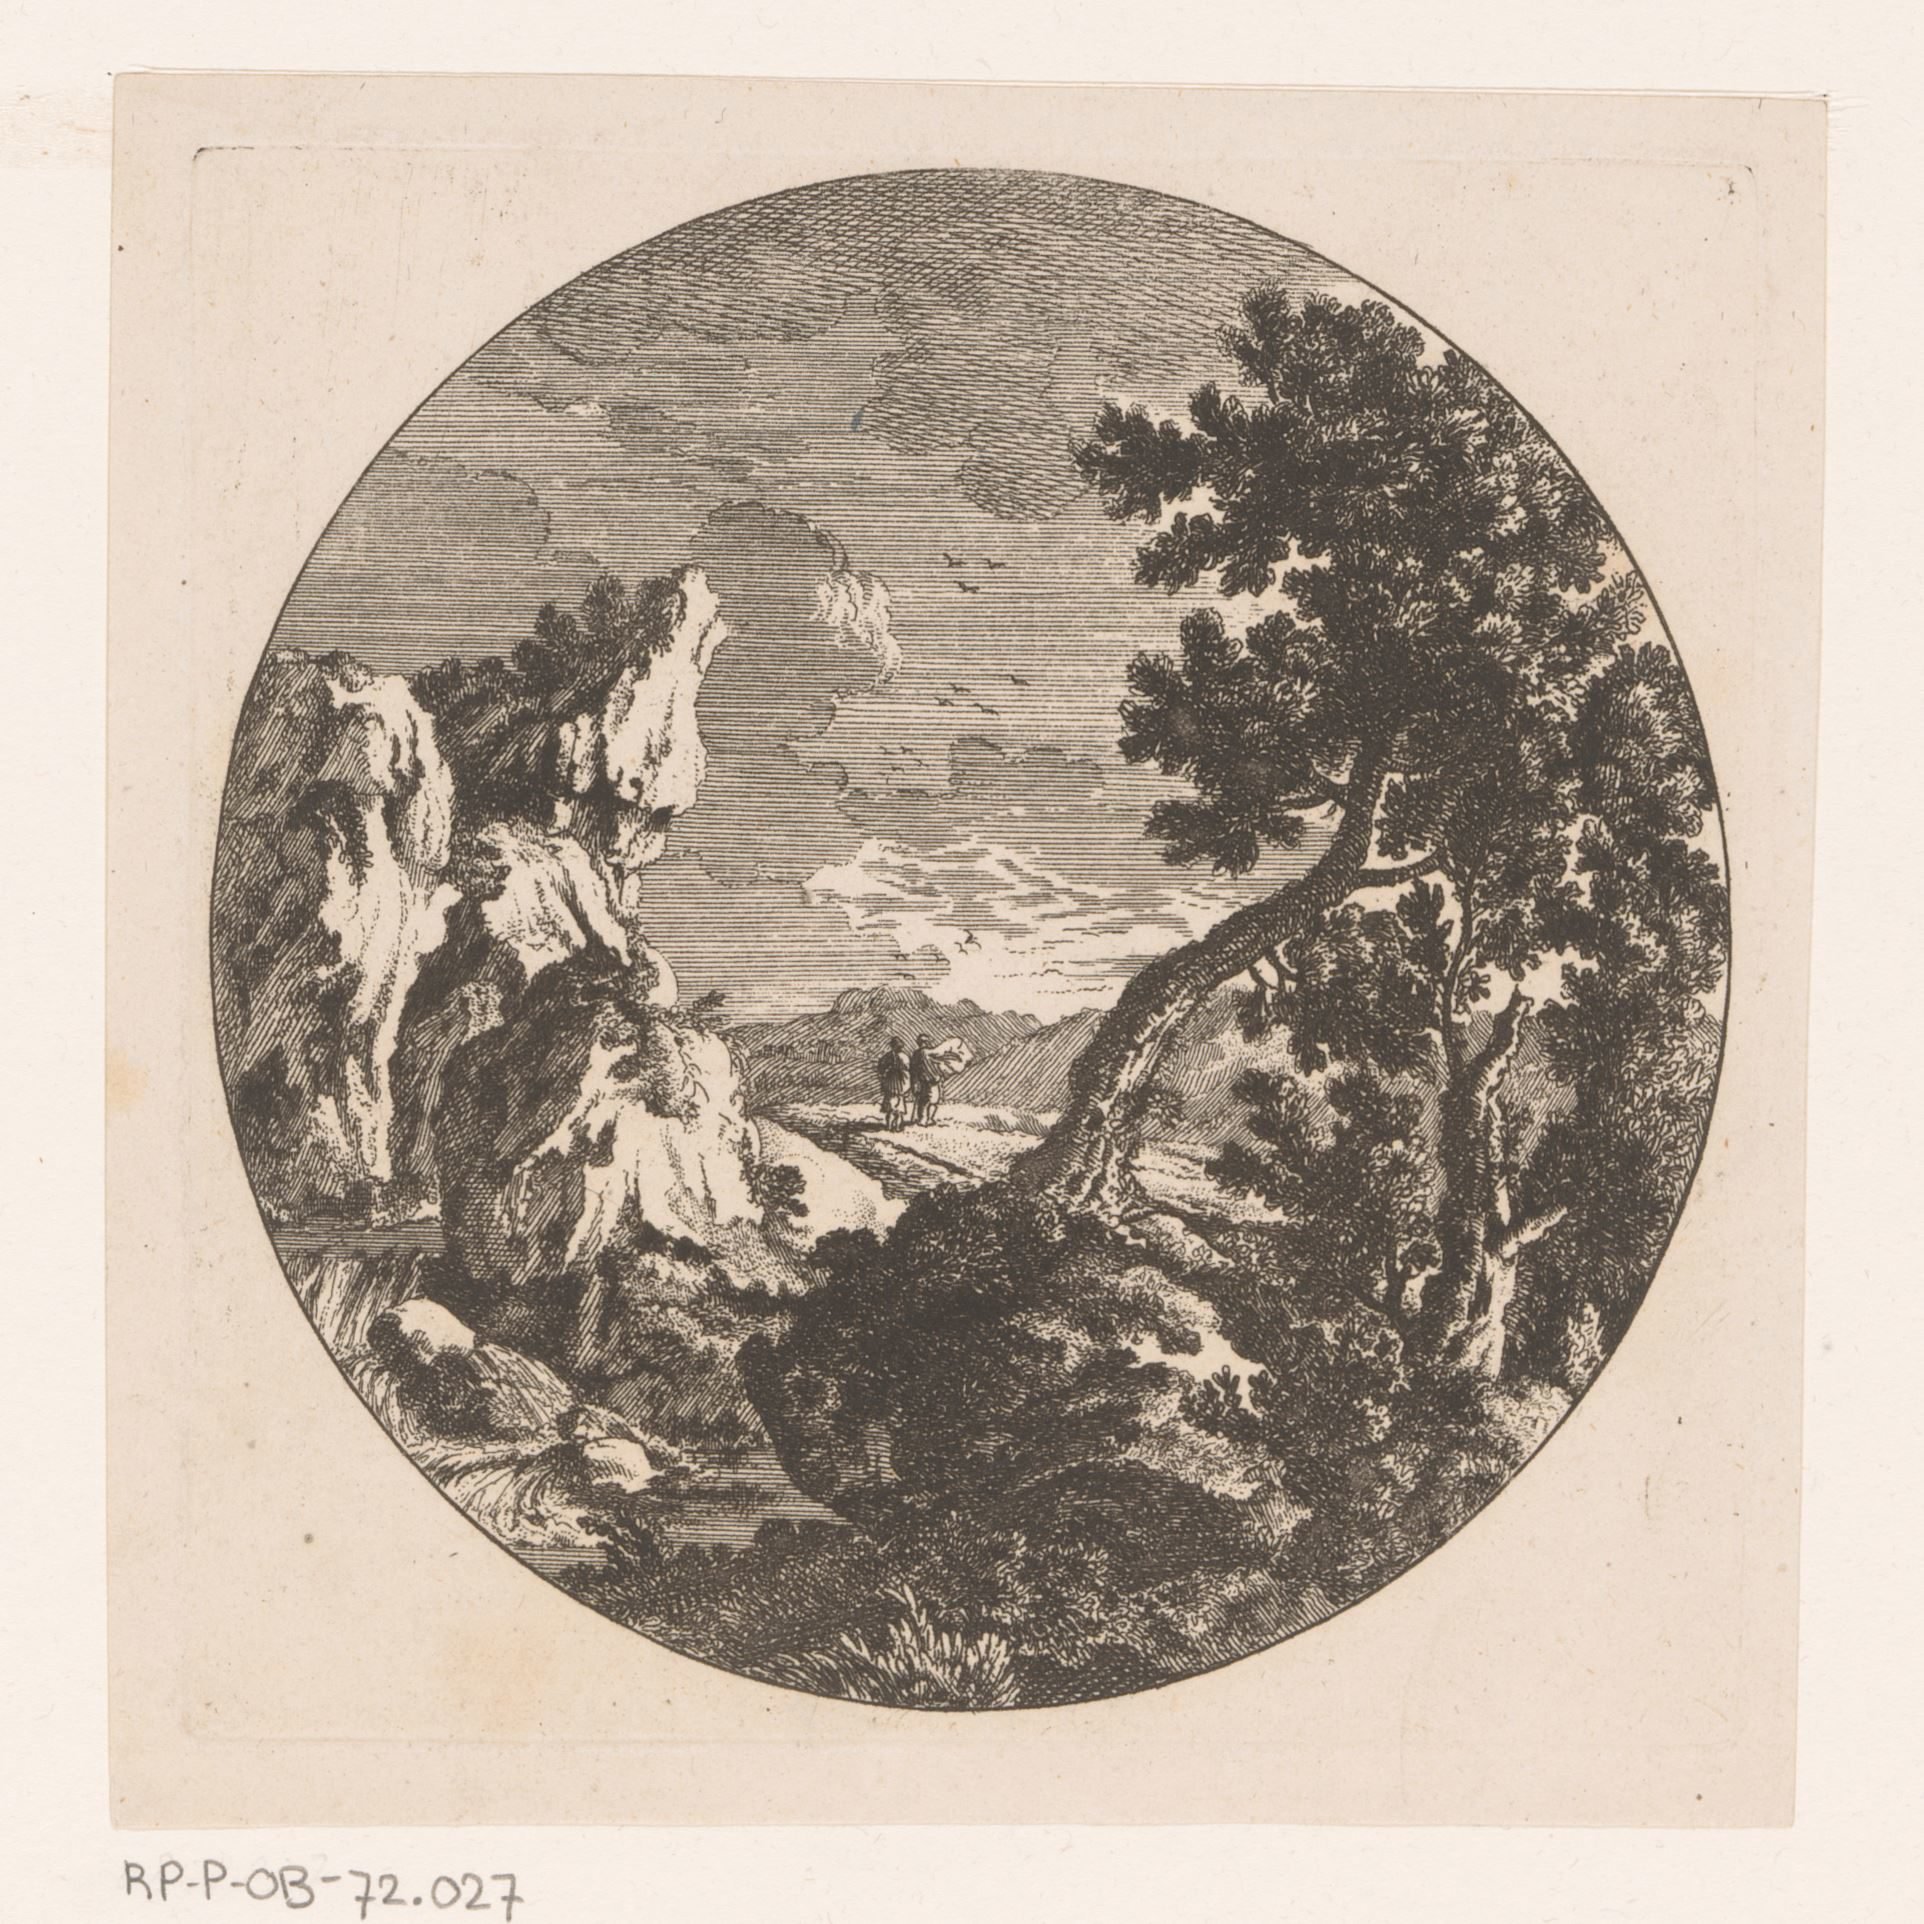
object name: print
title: Landschap met rotsen en twee wandelaars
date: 1613-1695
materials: paper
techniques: etching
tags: rocks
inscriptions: collector's mark: Lugt 2228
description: Prenten met het signatuur 'Perelle' kunnen zowel door vader Gabriel als door zonen Nicolas en Adam gemaakt zijn.